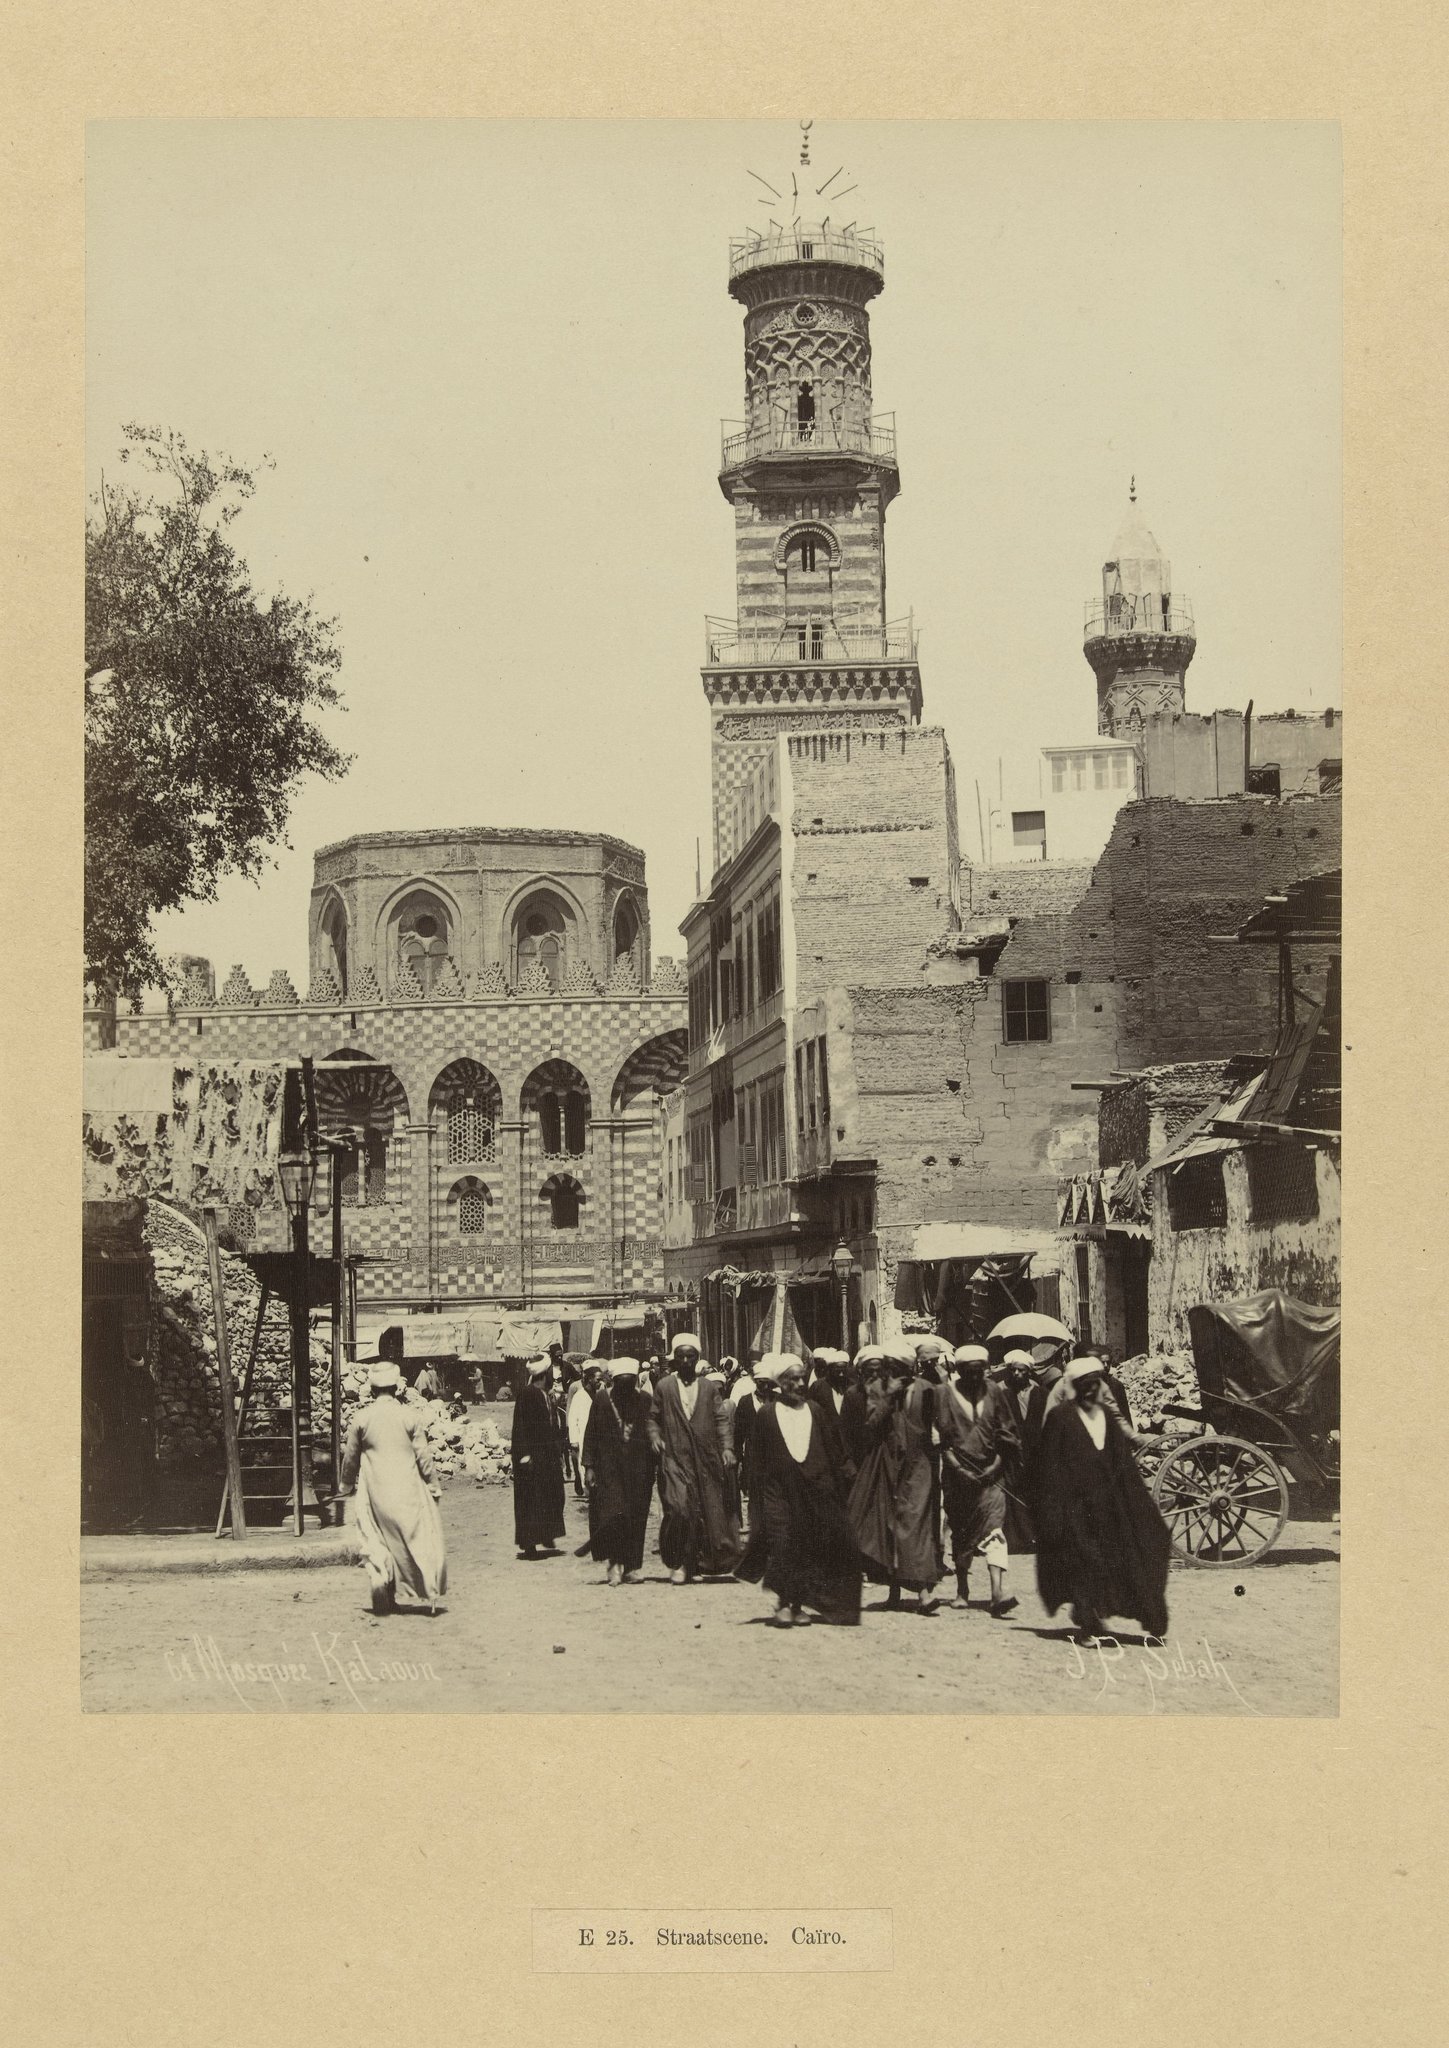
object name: photograph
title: E 25. Straatscene. Caïro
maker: jean pascal sébah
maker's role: fotograaf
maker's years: 1872-1947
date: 1888-1895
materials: cardboard, paper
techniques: albumen print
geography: cairo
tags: temple, shrine ~ islam, mohammedanism, street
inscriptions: stamp: ‘Gemeentelijke bibliotheek/ Rotterdam’, check stamp: ‘Bristol/ L.M.’, number: ‘64’, title: ‘E 25. Straatscene. Caïro.’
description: Onderdeel van een groep door fotograaf Richard Polak op reis verzamelde foto’s. Deze foto is samen met andere op zijn reizen verzamelde foto's tentoongesteld bij de Rotterdamsche Kunstkring (1895), Arti en Amicitiae te Amsterdam (1897-1898?) en Societeit 't Collegie te Kampen (datum vooralsnog onbekend).